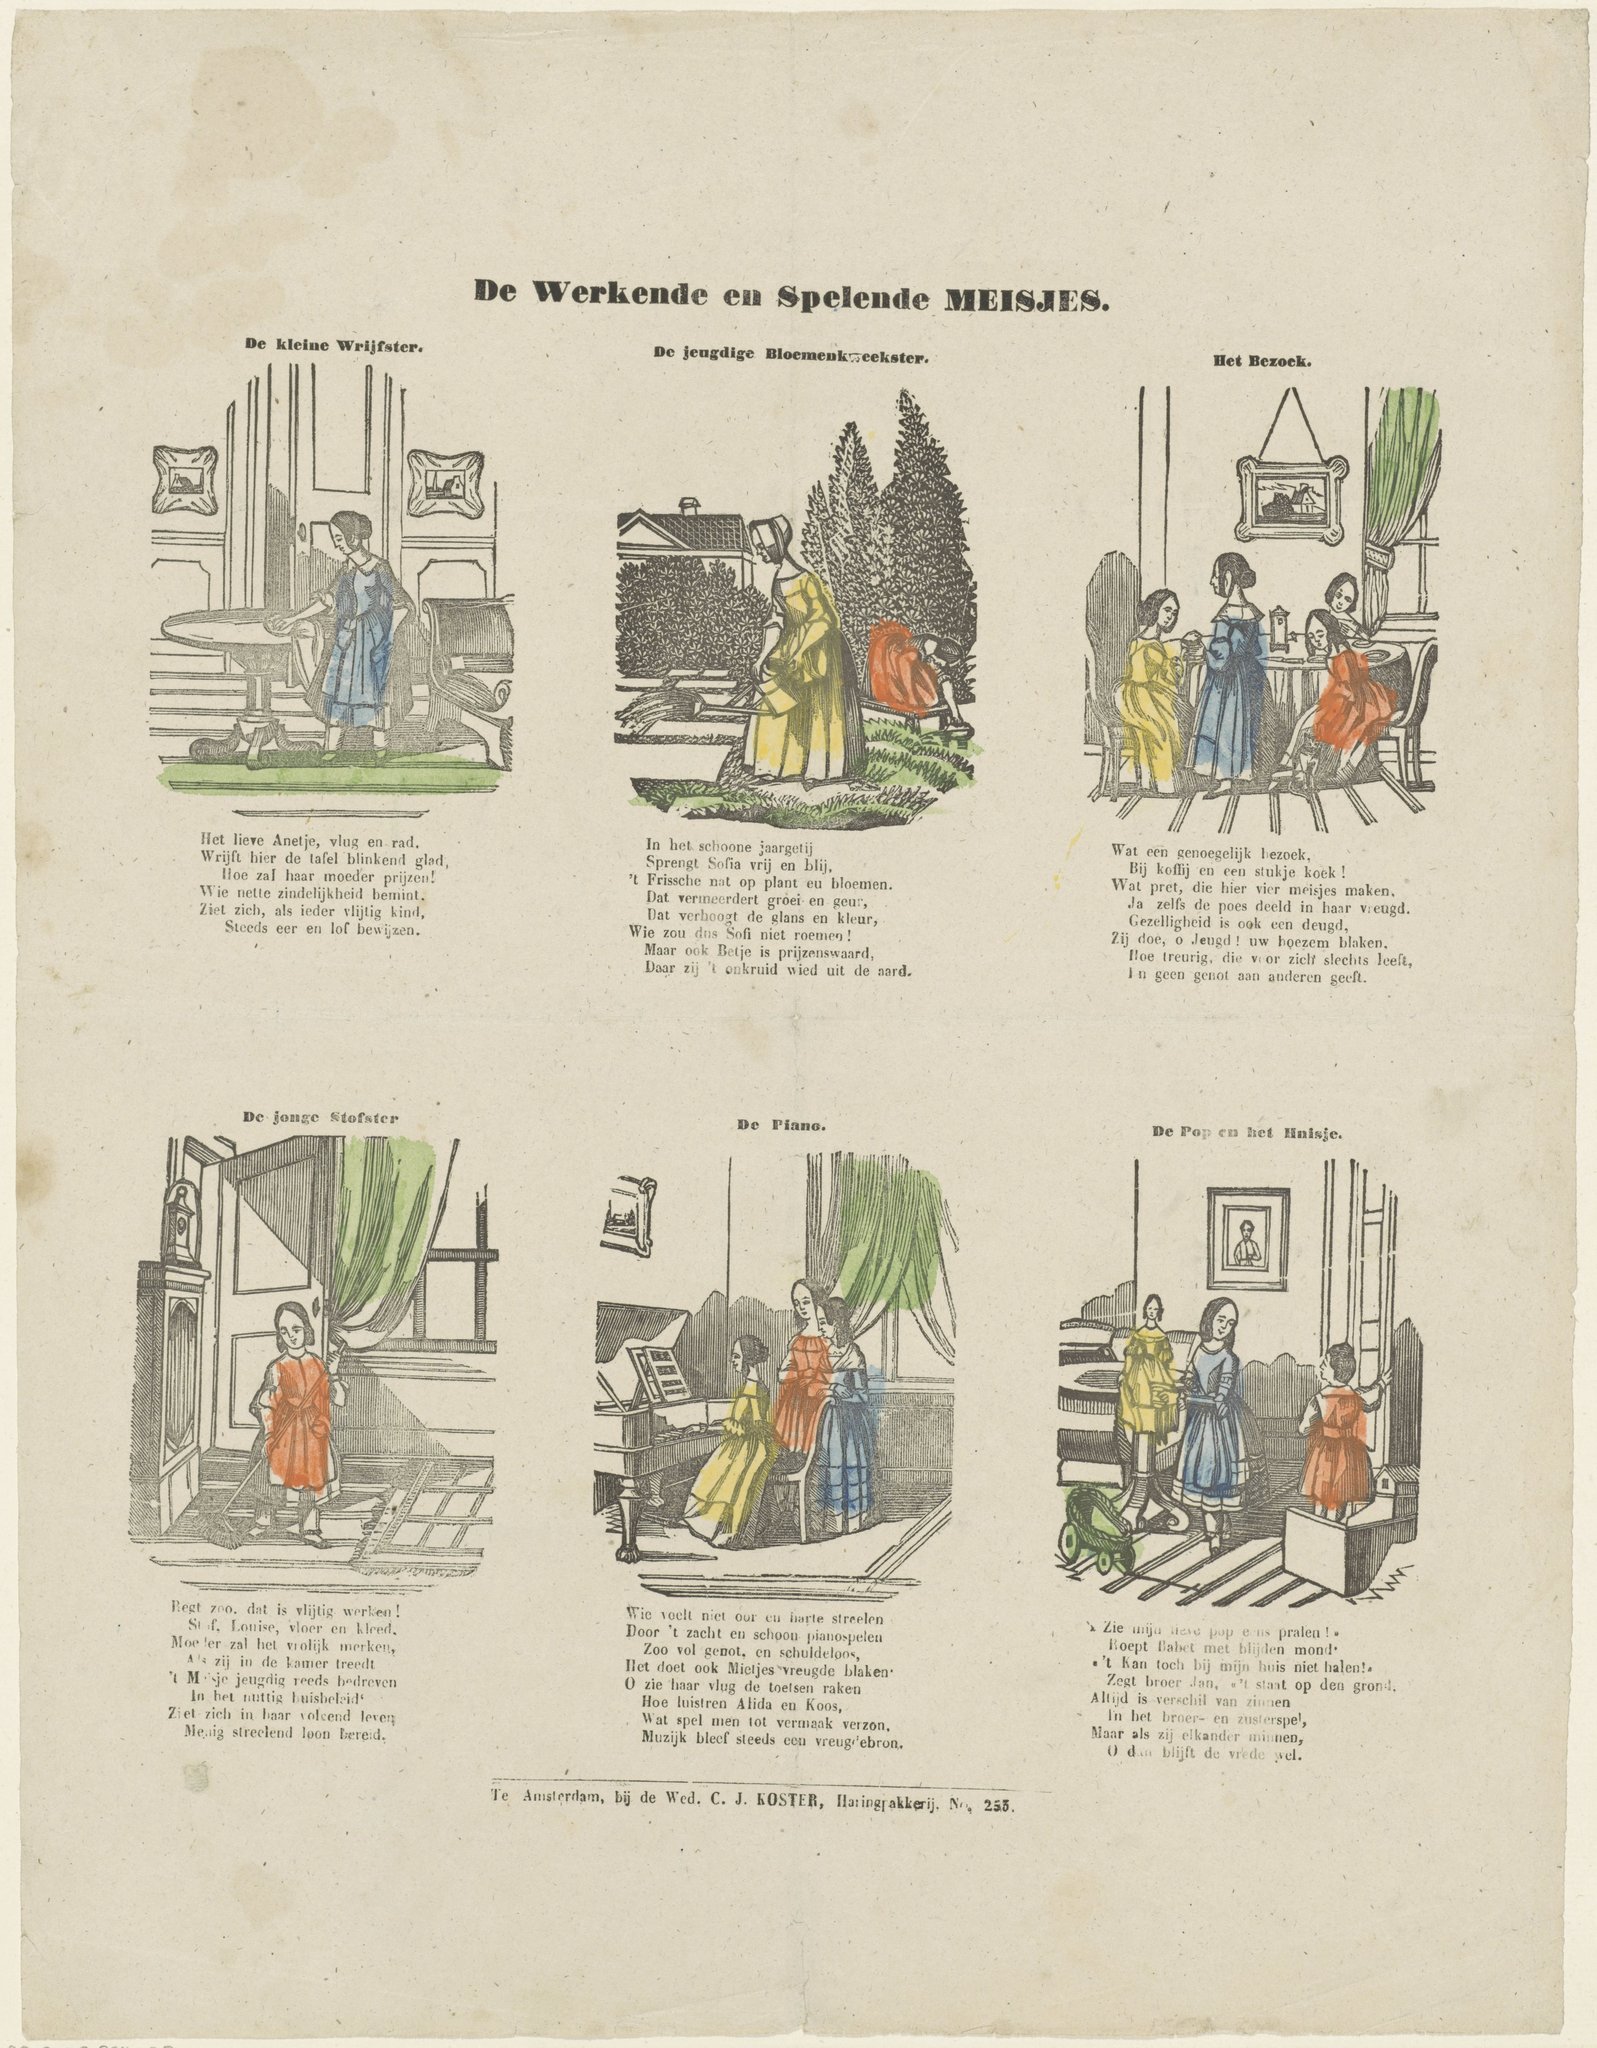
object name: print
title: De werkende en spelende meisjes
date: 1825-1847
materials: paper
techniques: colour, letterpress printing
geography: netherlands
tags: children's games and plays, child, child playing with animals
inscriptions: collector's mark: Lugt 2760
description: Blad met 6 voorstellingen van werkende en spelende meisjes, waaronder een meisje dat schoonmaakt, een meisje dat de planten water geeft en een meisje dat piano speelt. Onder elke afbeelding een zes- of achtregelig vers en boven elke afbeelding een titel.